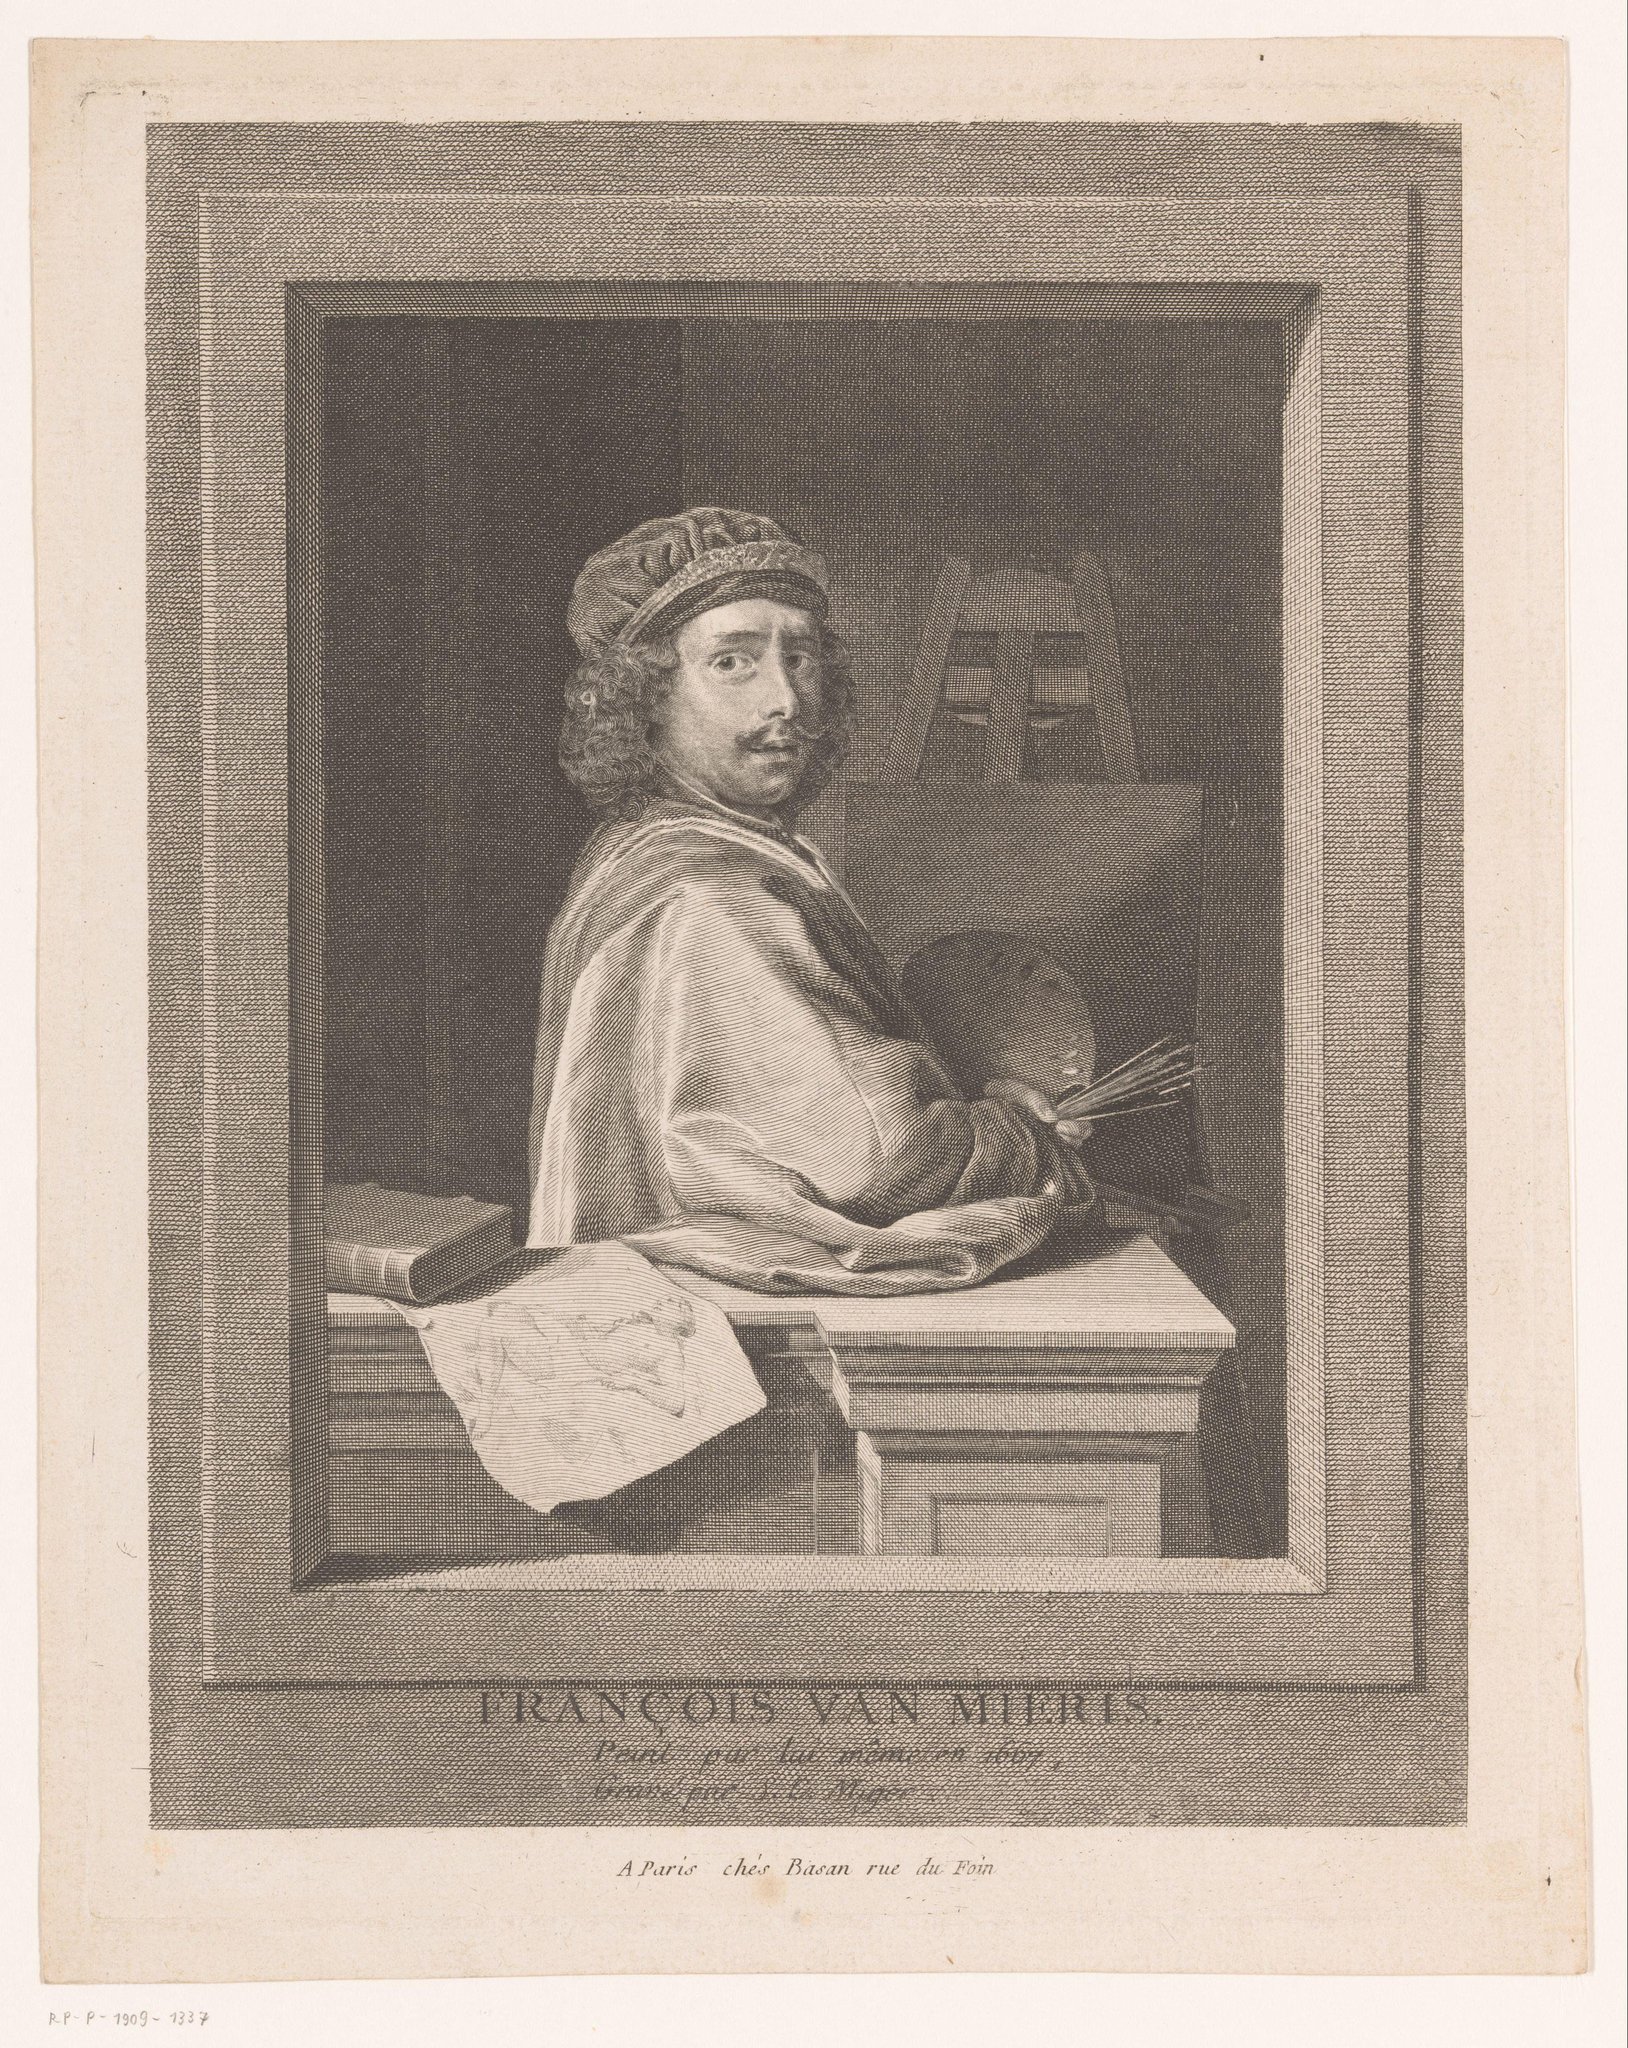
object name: print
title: François van Mieris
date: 1750-1788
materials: paper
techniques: engraving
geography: paris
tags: leiden, painter, print maker, draughtsman, frans van mieris (i), historical persons, portrait, self-portrait of painter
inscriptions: collector's mark: Lugt 2228